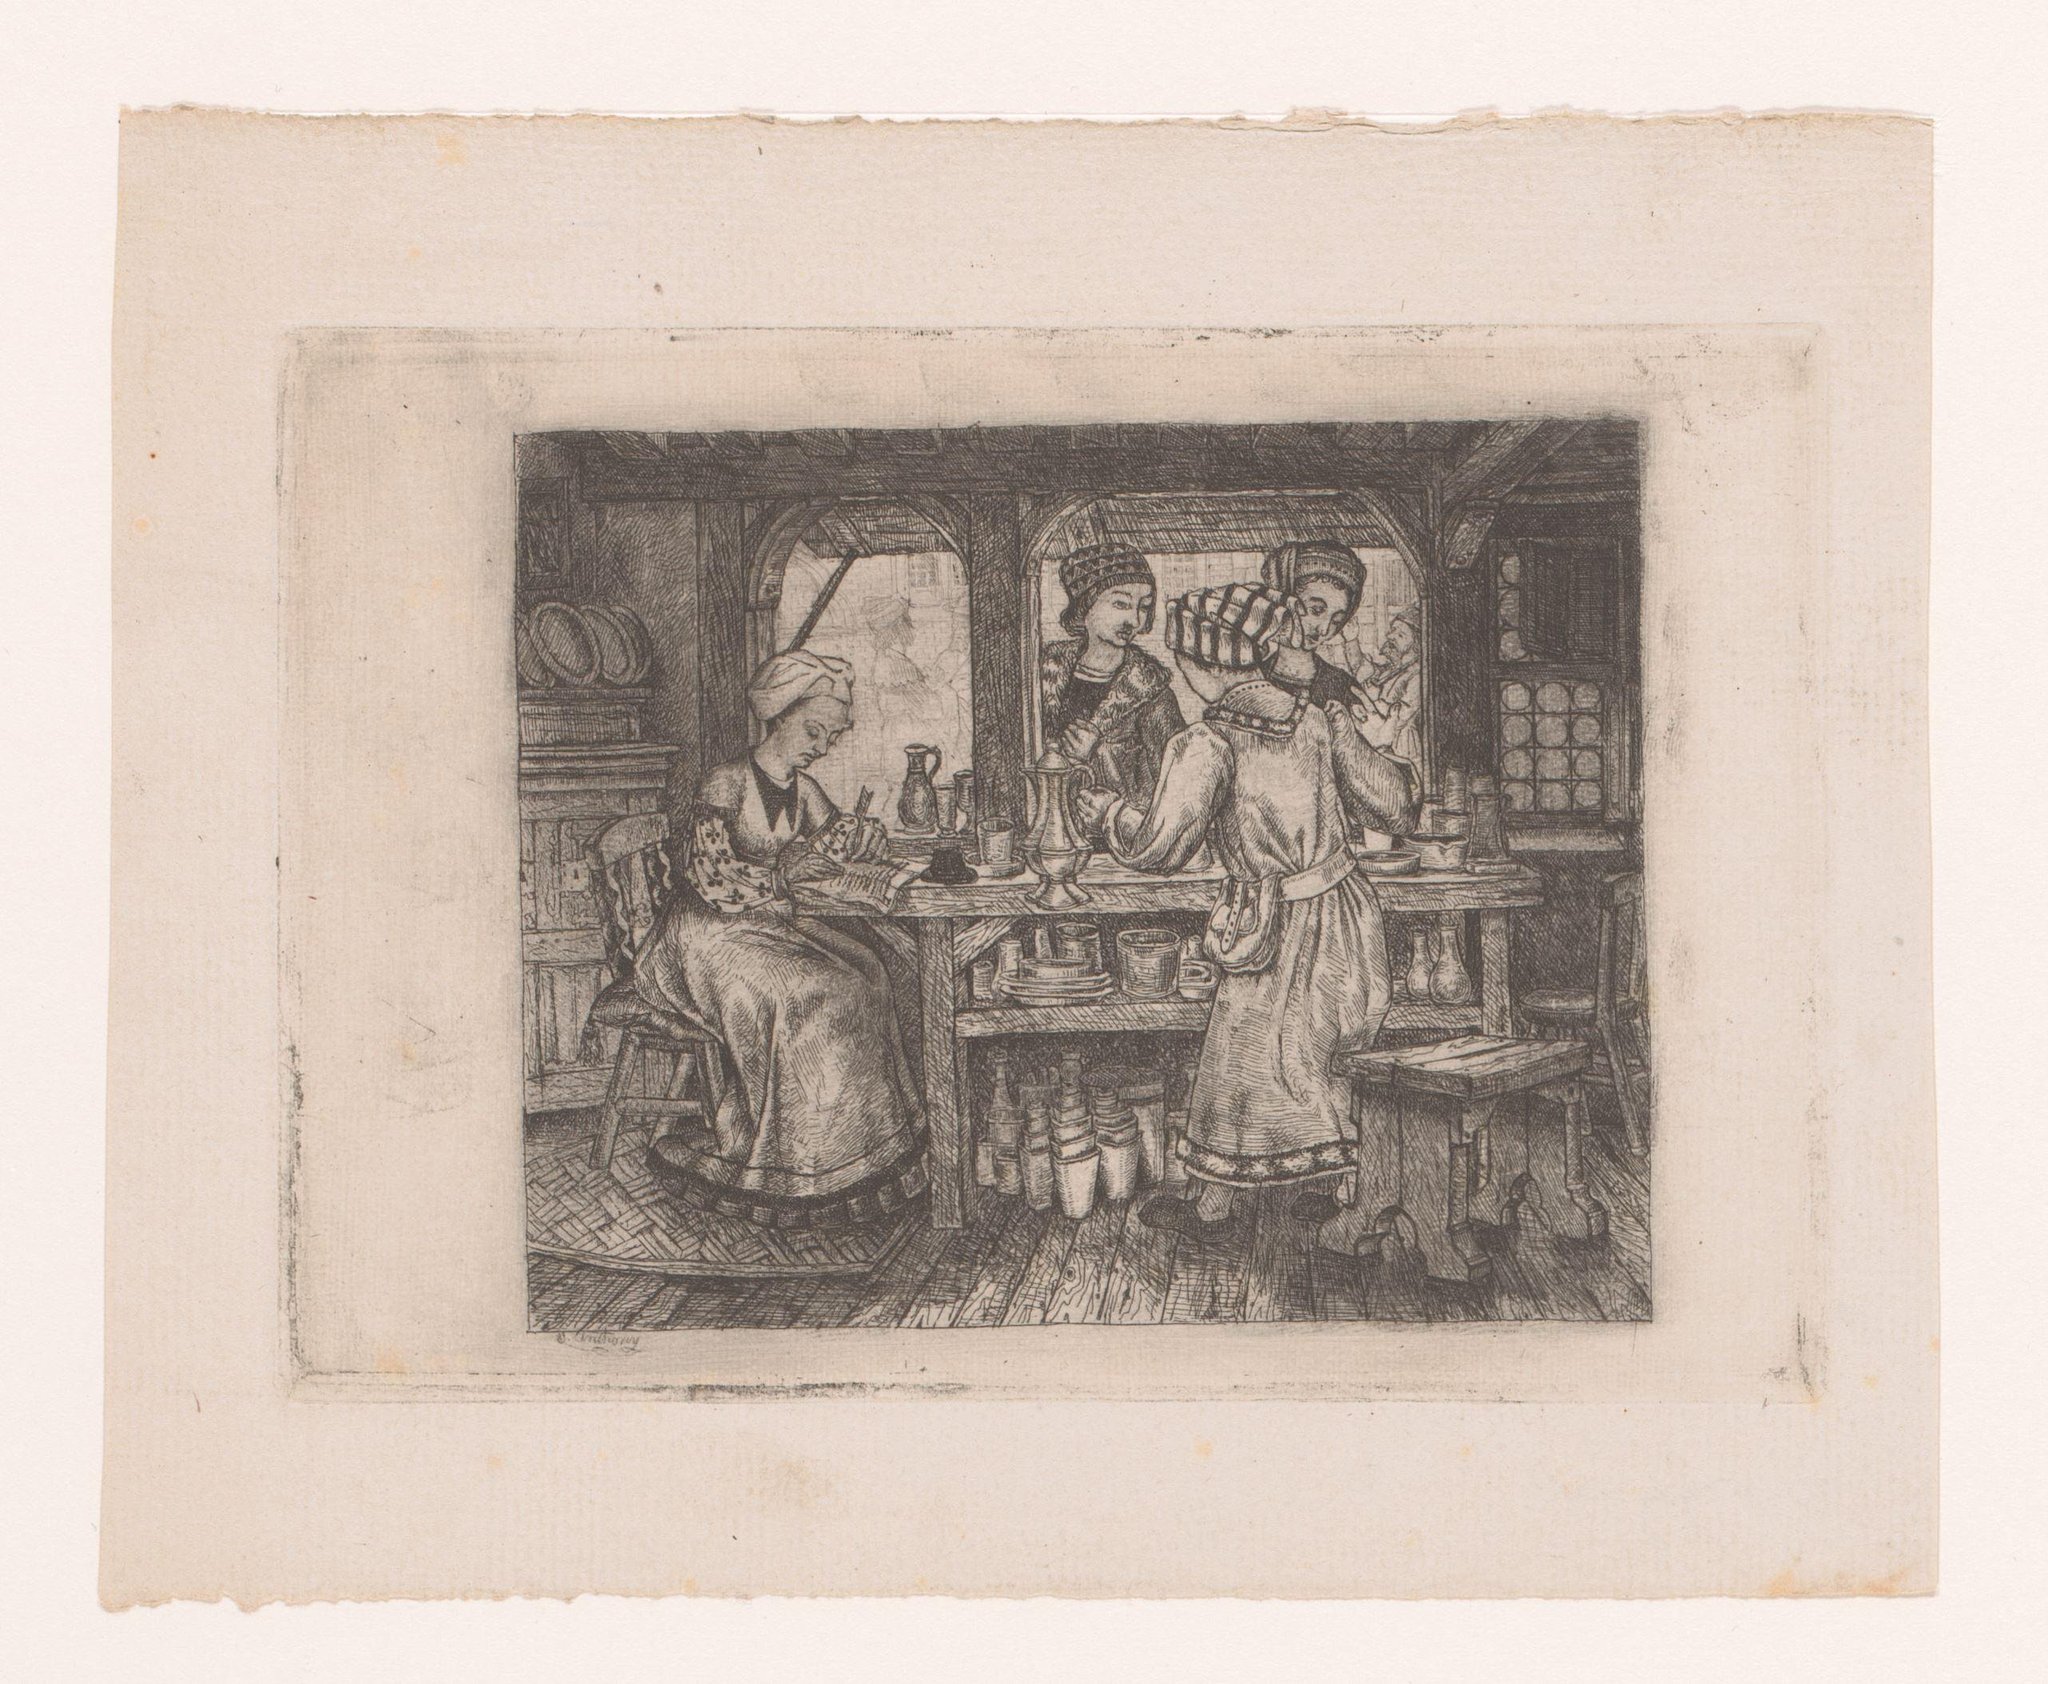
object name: print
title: Winkel van een middeleeuwse zilversmid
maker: jean-baptiste anthony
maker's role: painter, print maker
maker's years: 1854-1930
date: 1864-1909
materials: paper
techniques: etching, intaglio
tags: counter ~ shop, jeweller, goldsmith, silversmith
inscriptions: collector's mark: Lugt 2228